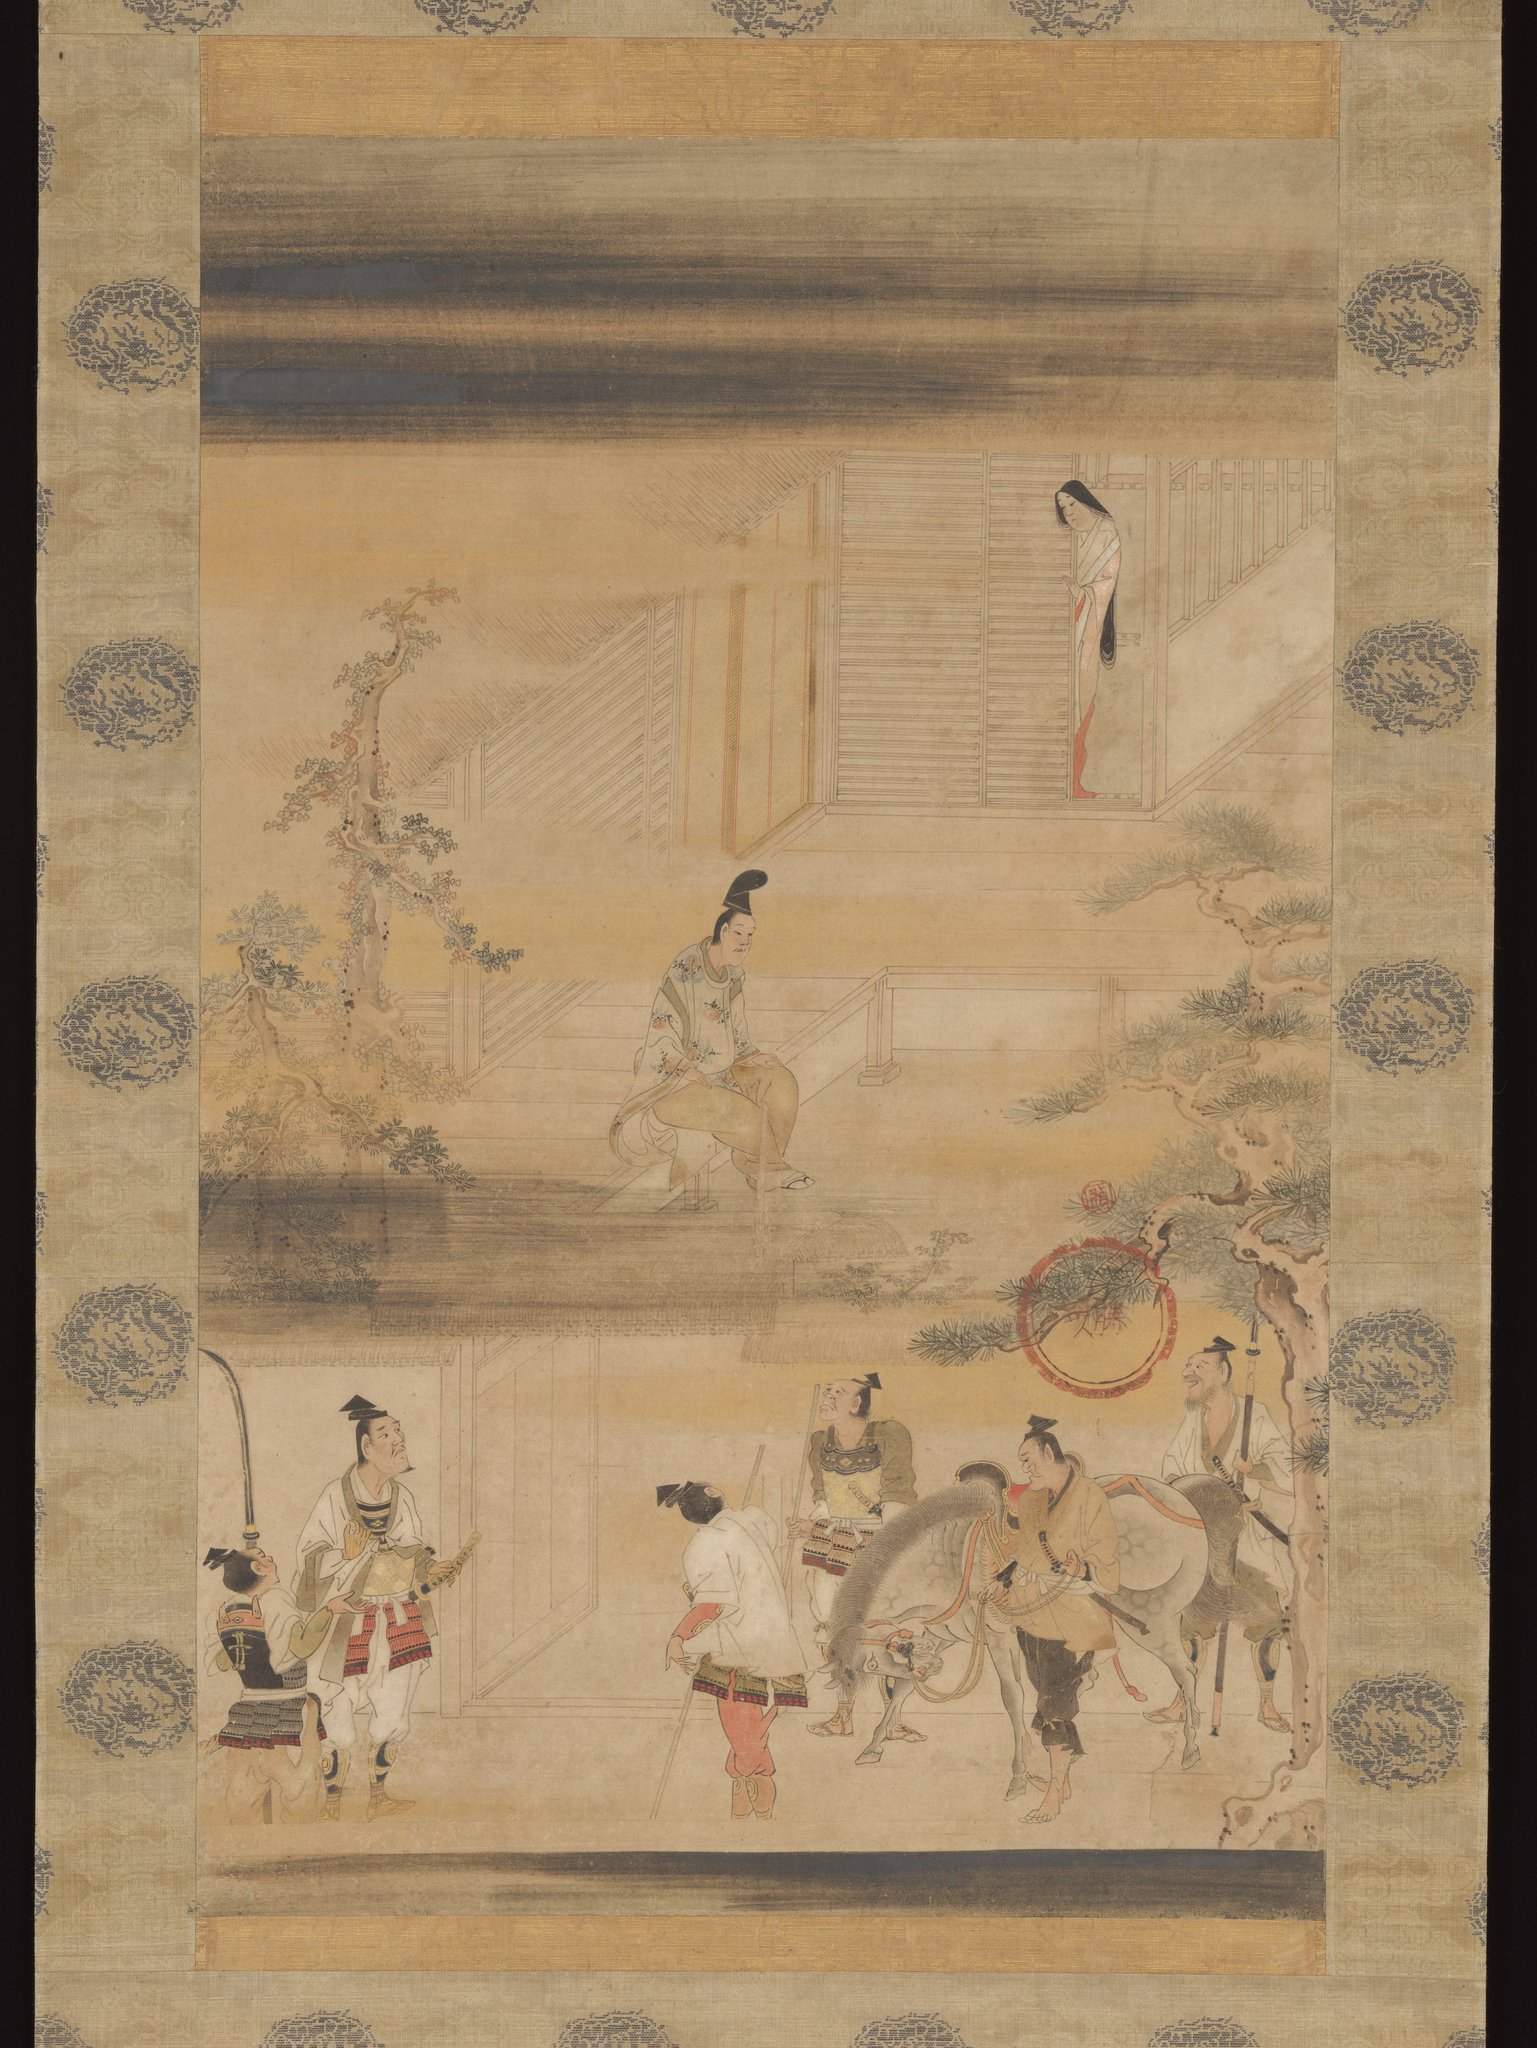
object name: hanging scroll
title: “Taira no Koremori’s Farewell,” from The Tale of the Heike (Heike monogatari)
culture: japanese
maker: iwasa matabei (katsumochi)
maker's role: artist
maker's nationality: japanese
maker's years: 1578-1650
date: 1640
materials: gold, ink, paper, silver